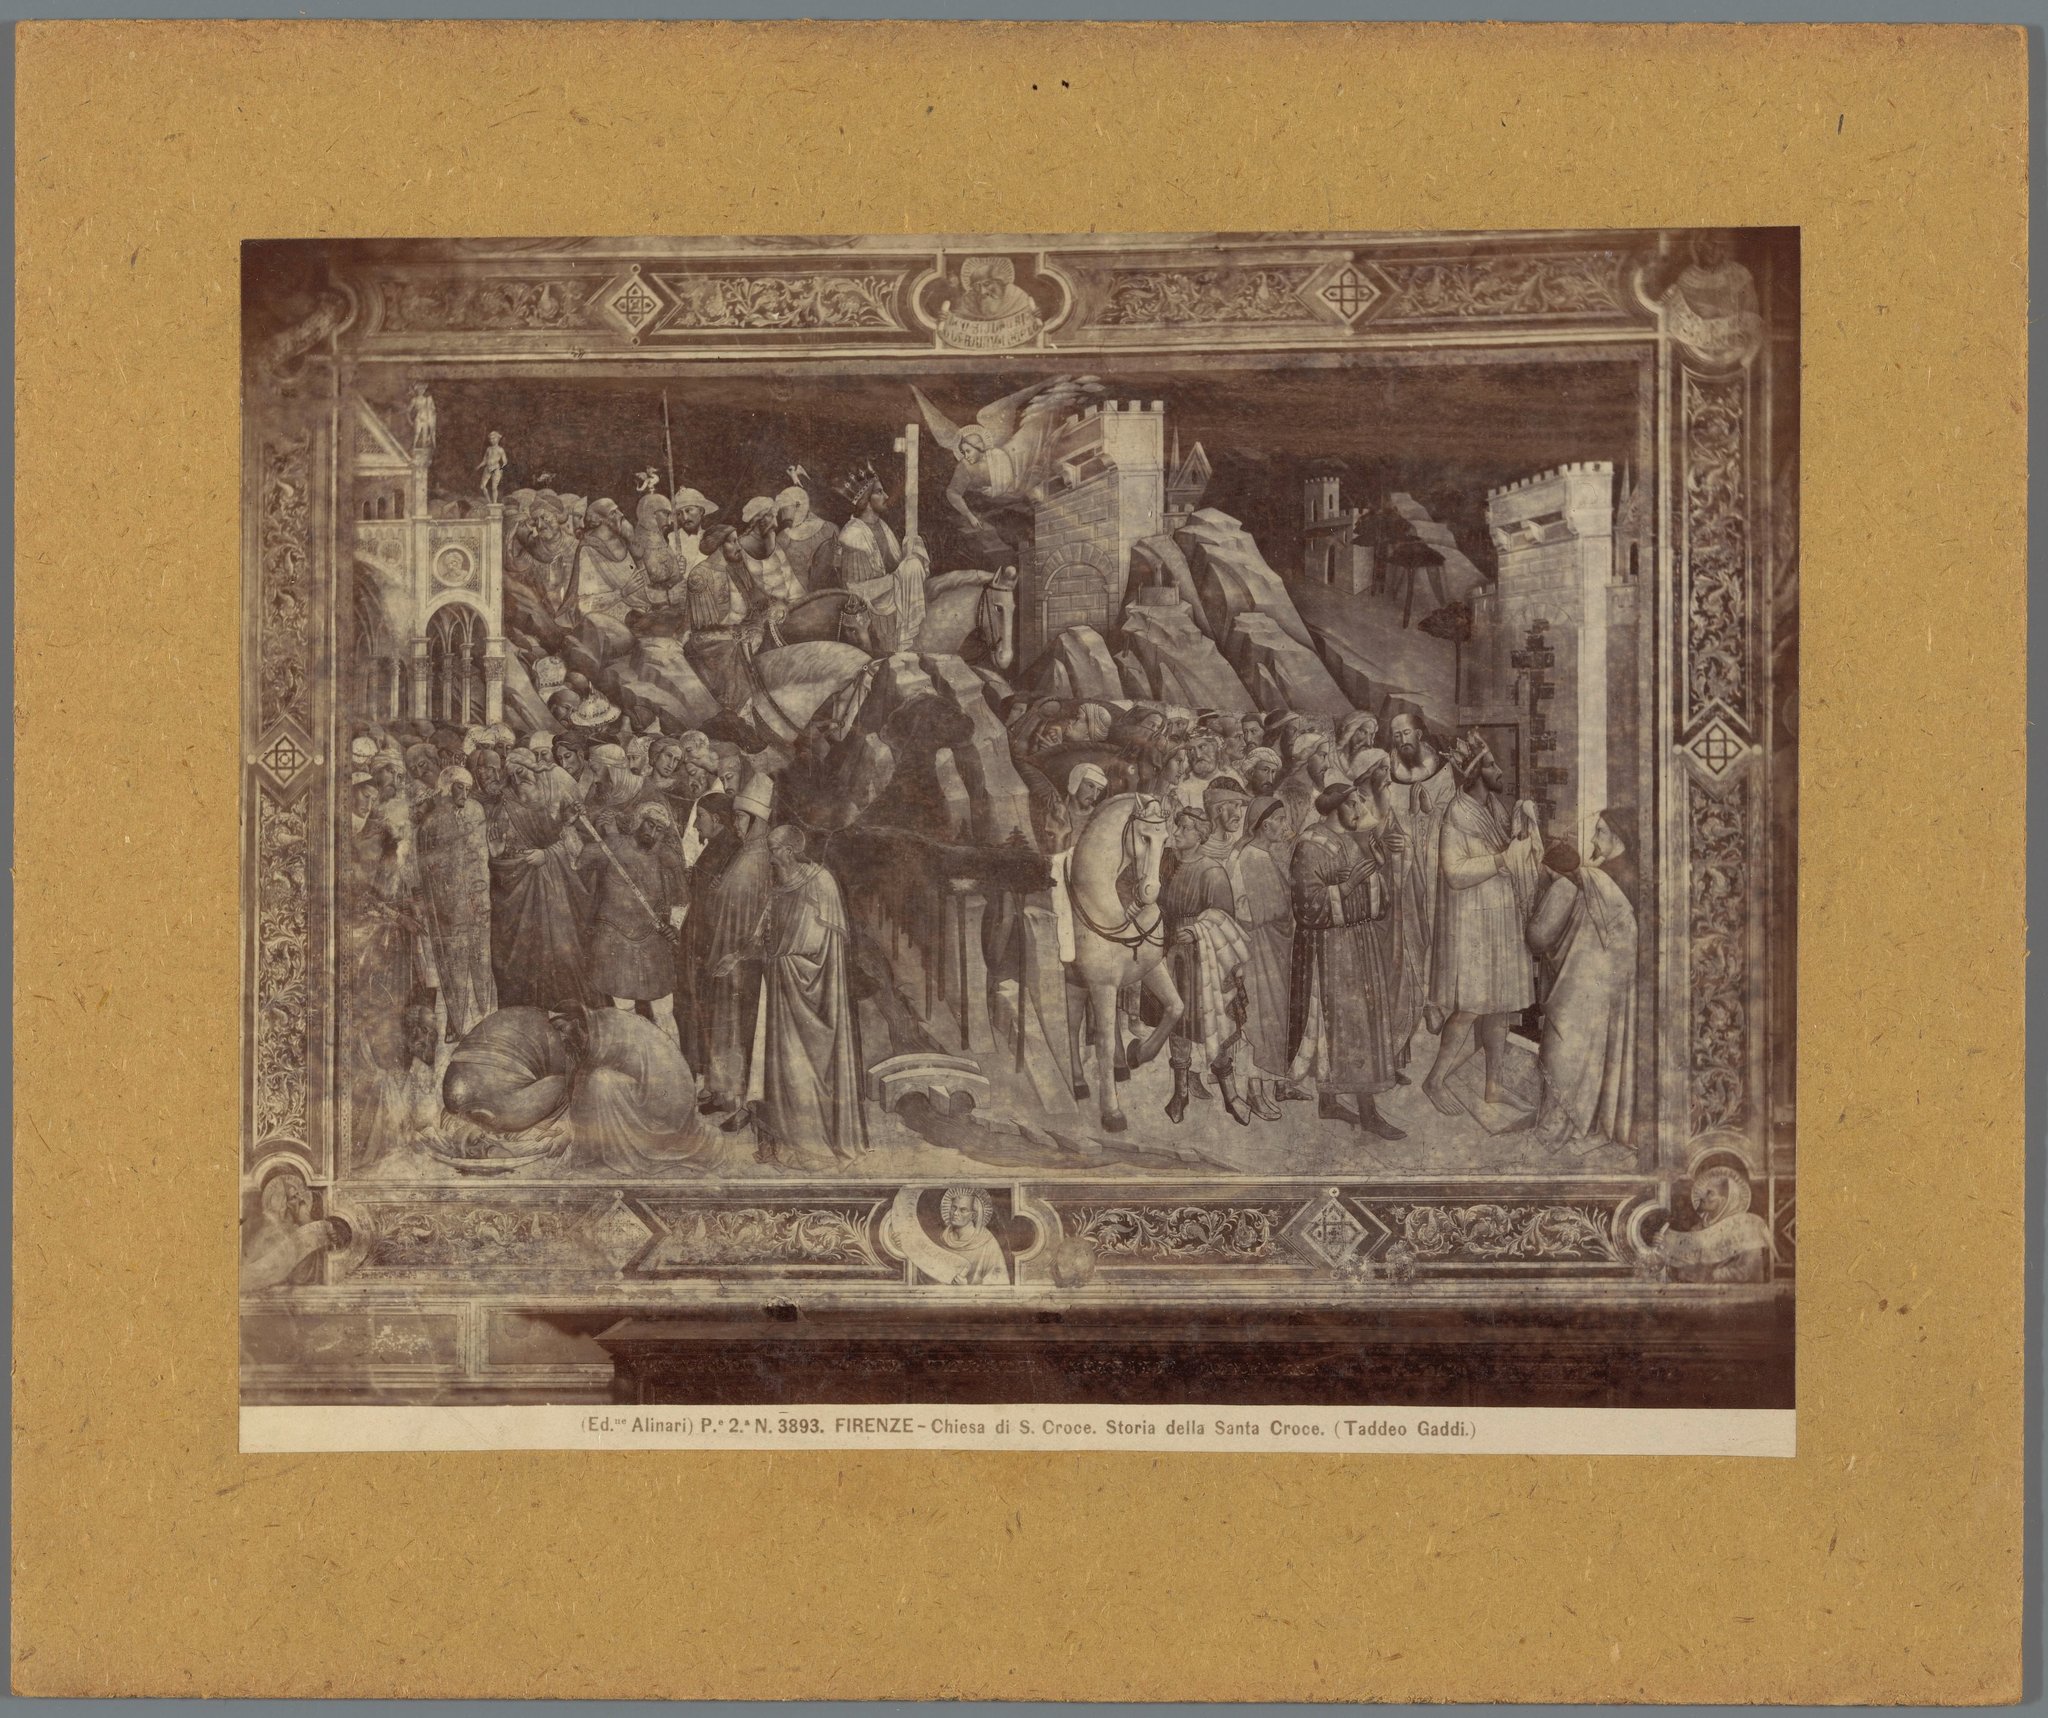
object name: photograph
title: FIRENZE - Chiesa di S. Croce. Storia della Santa Croce.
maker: taddeo gaddi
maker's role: painter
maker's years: 1290-1366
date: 1875-1900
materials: cardboard, photographic support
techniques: albumen print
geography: santa croce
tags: chosroes ii, having refused baptism, is executed ~ legend of the true cross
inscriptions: collector's mark: Lugt 3937, number: ‘P.e 2.a N.o 3893.’